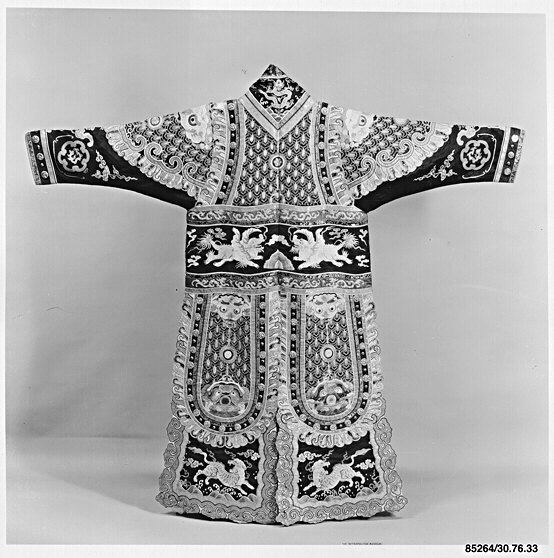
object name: robe, imperial theatrical, for guard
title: Theatrical Robe for the Role of a Guard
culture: chinese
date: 1701-1800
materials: metal thread, silk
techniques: appliqué, embroidery, weave